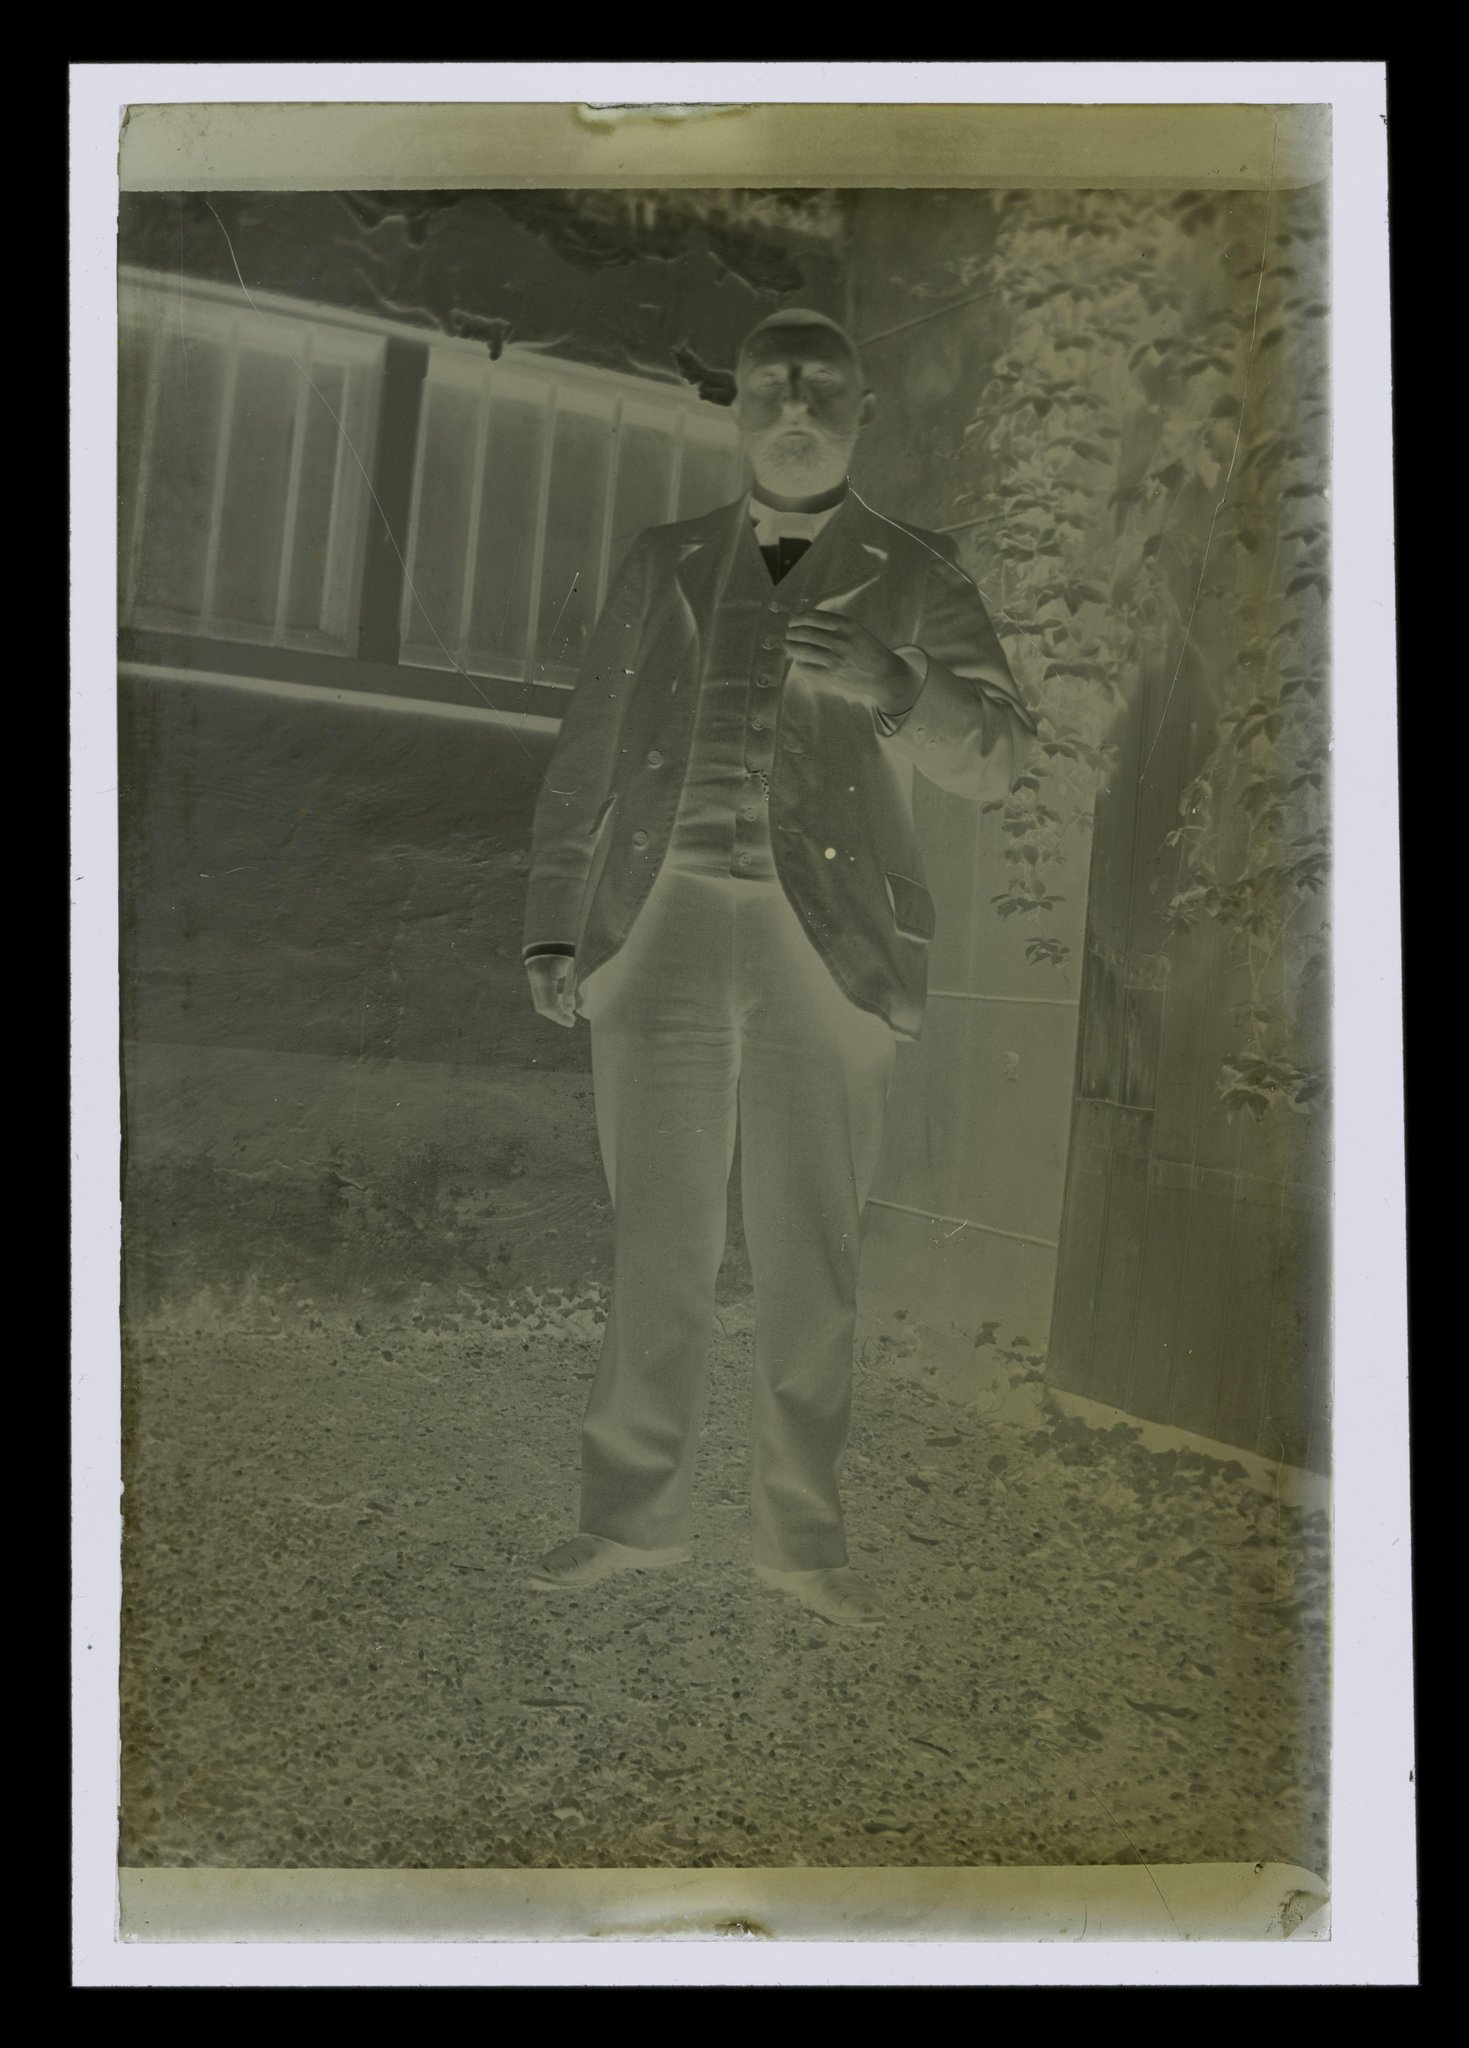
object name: glasnegatief, glasplaatnegatief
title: Portret van een onbekende man, staande in een tuin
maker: laurens lodewijk kleijn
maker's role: draughtsman, painter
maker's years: 1826-1909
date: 1865-1900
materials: glass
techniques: collodion process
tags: garden, anonymous historical person portrayed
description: Onderdeel van groep glasnegatieven uit de nalatenschap van de schilder Laurens Lodewijk Kleijn, stillevens, portretten, zelfportretten en kunstreproducties.